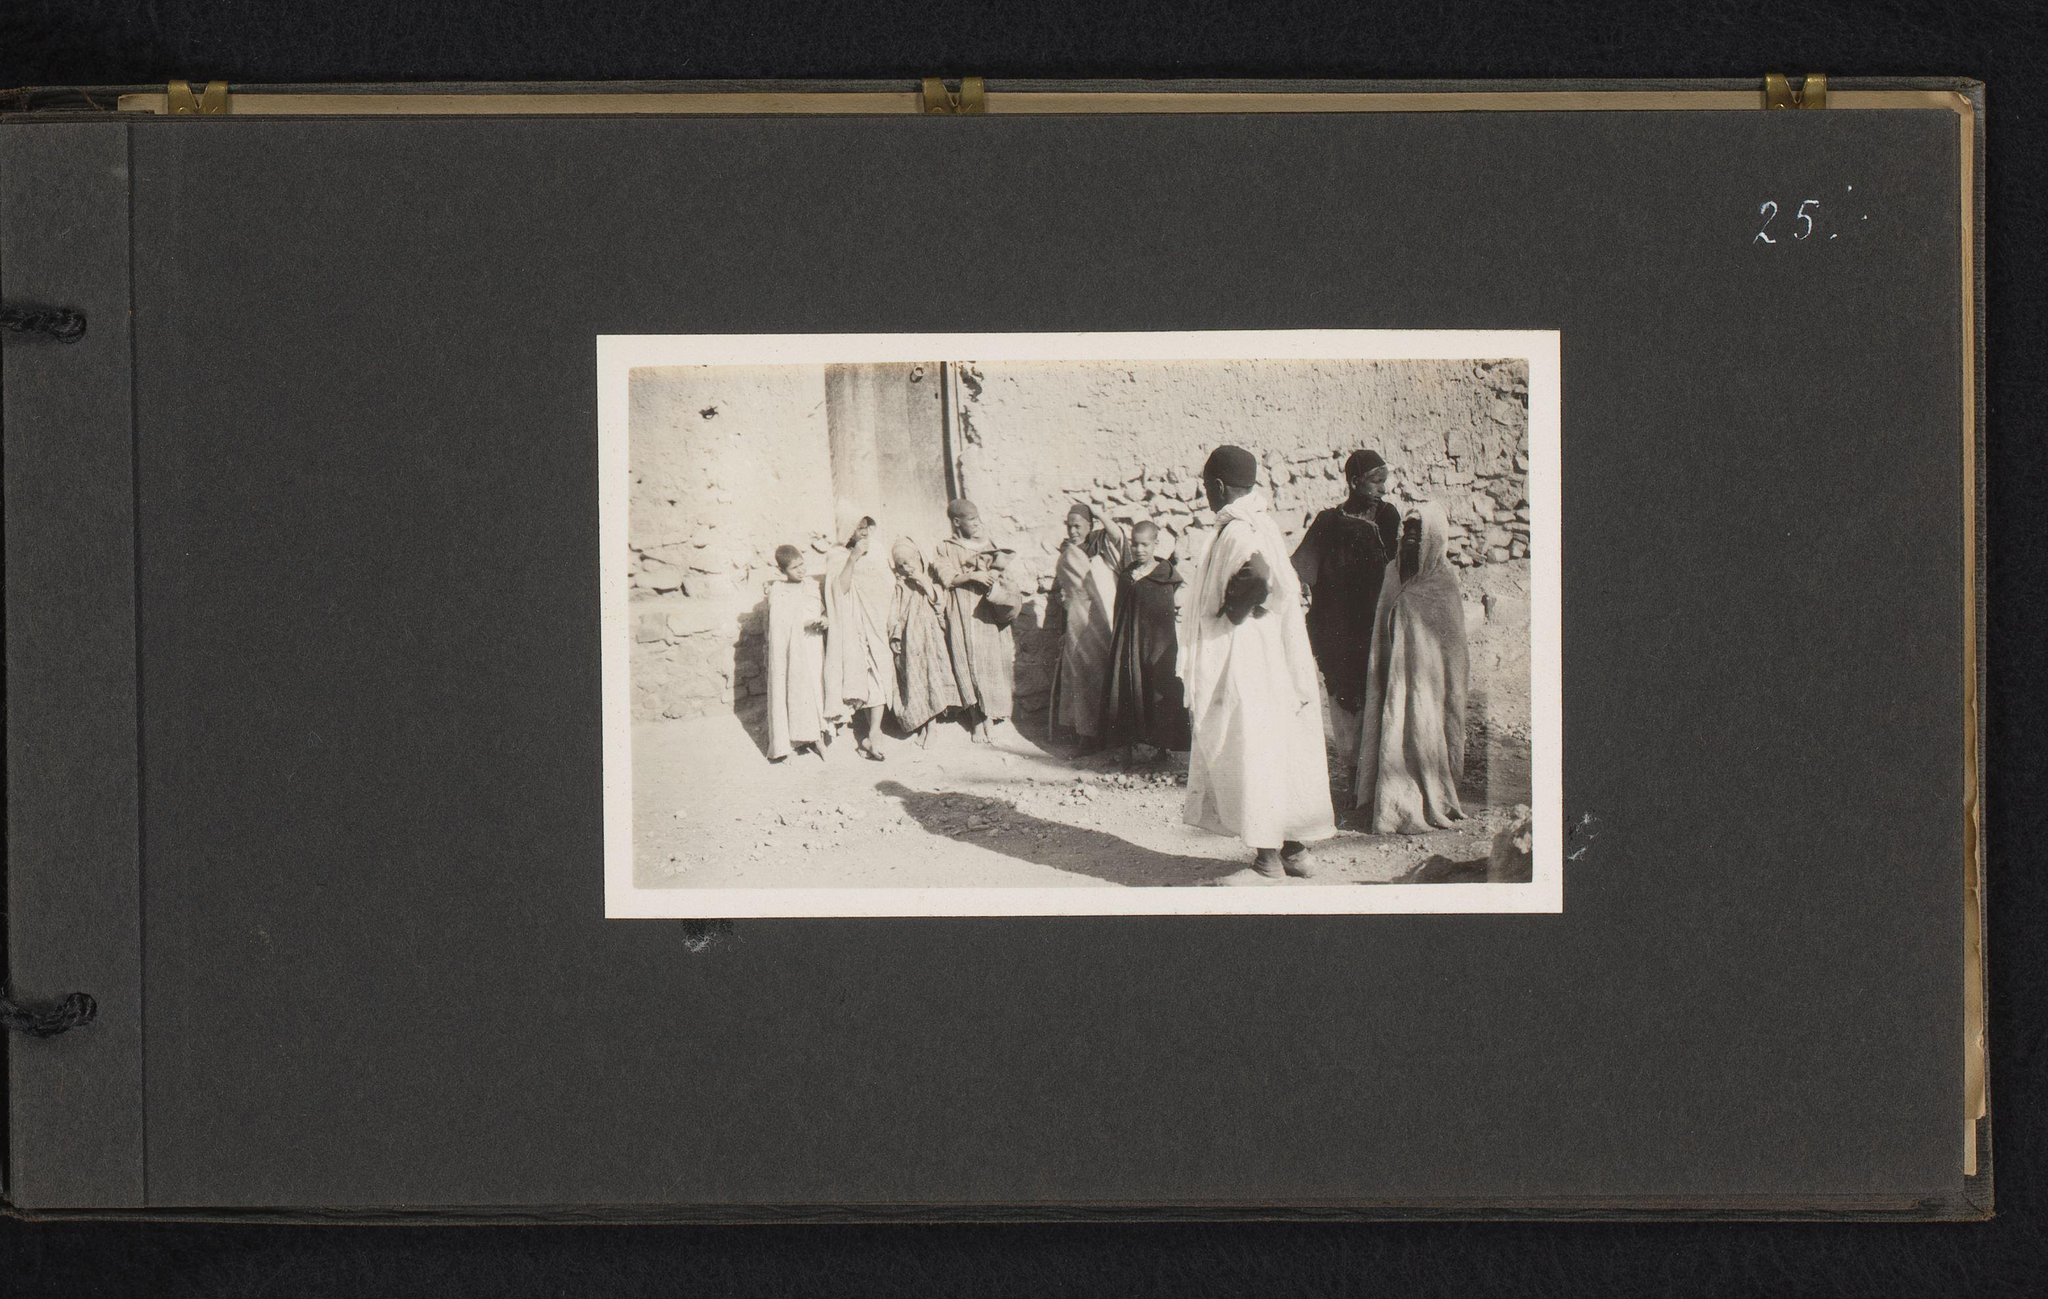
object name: album leaf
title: Groep belangstellenden in Oudaghir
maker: a.g.a. van eelde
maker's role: engineer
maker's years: 1862-1950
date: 1927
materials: paper, photographic support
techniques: gelatin silver print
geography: morocco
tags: child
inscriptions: number: ‘25.’